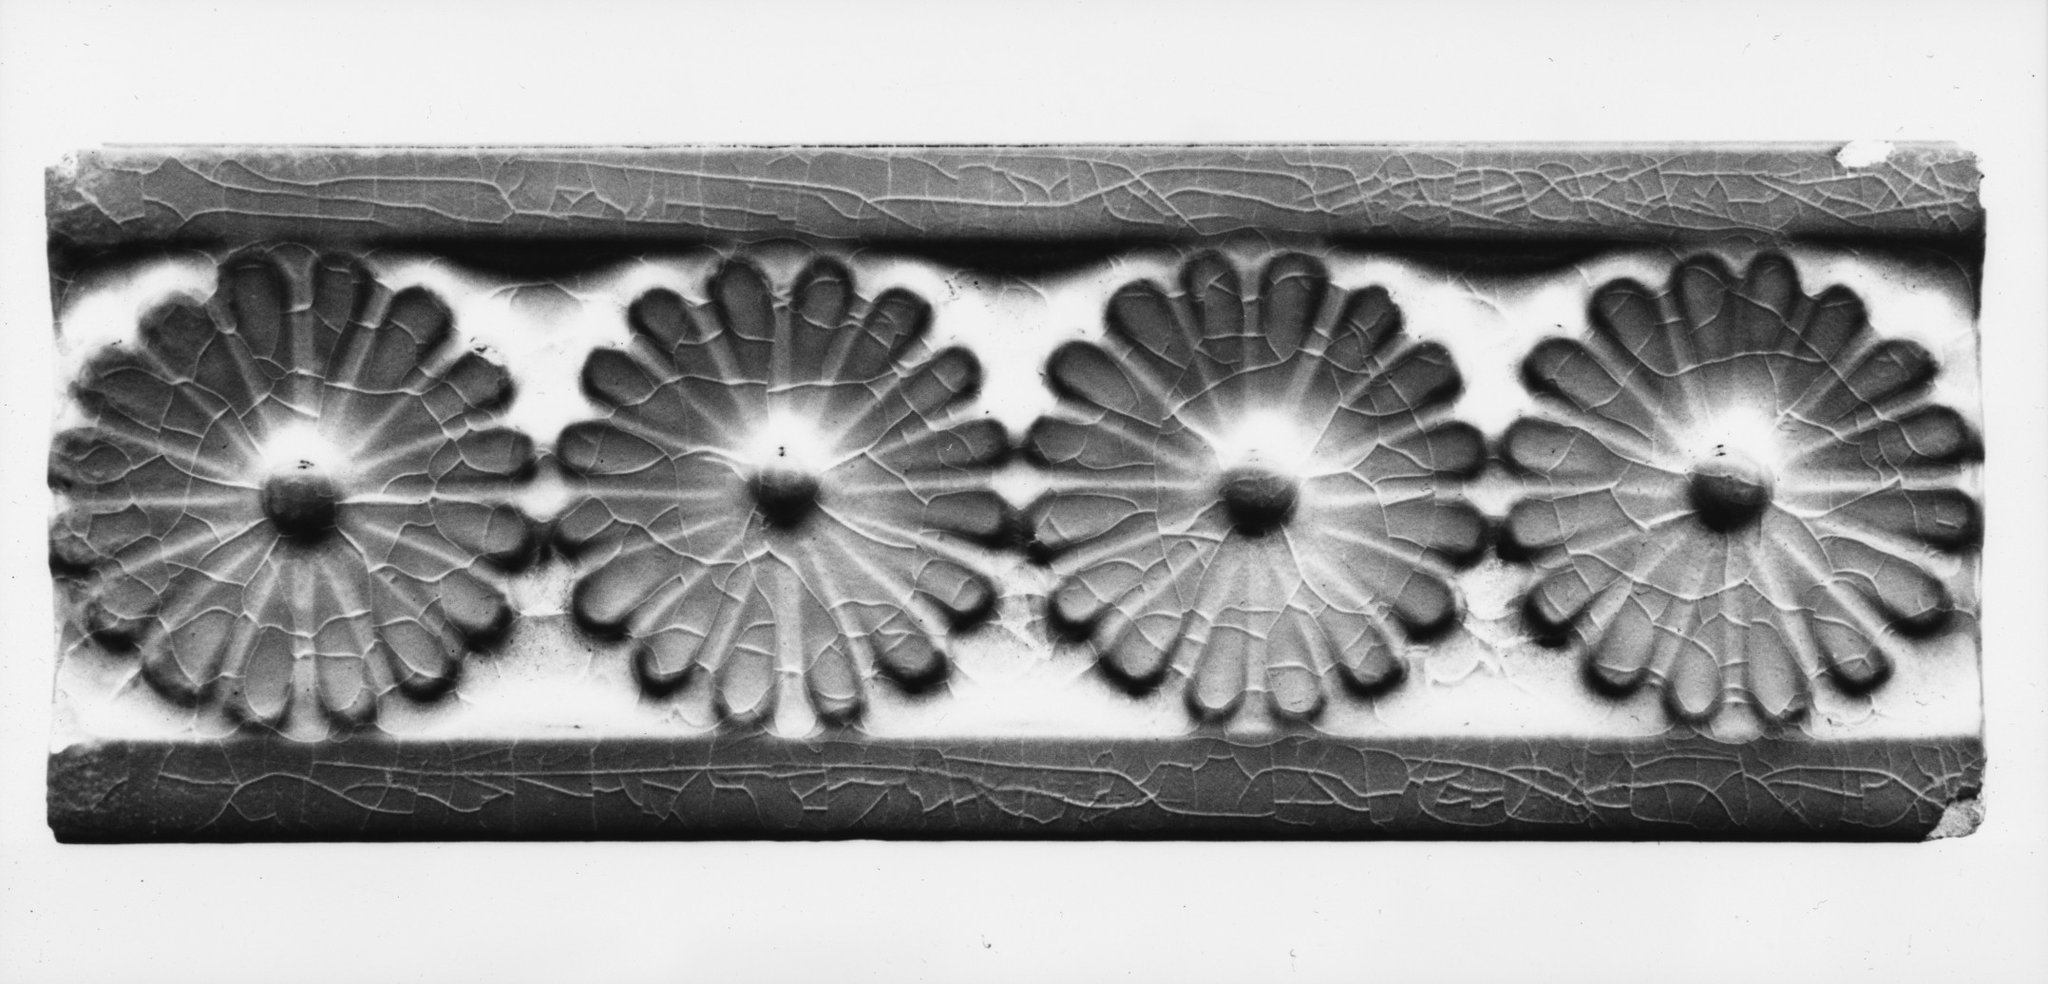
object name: tile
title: Border Tile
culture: american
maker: j. and j. g. low art tile works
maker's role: maker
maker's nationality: american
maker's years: 1877-1903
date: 1881-1885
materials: earthenware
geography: united states